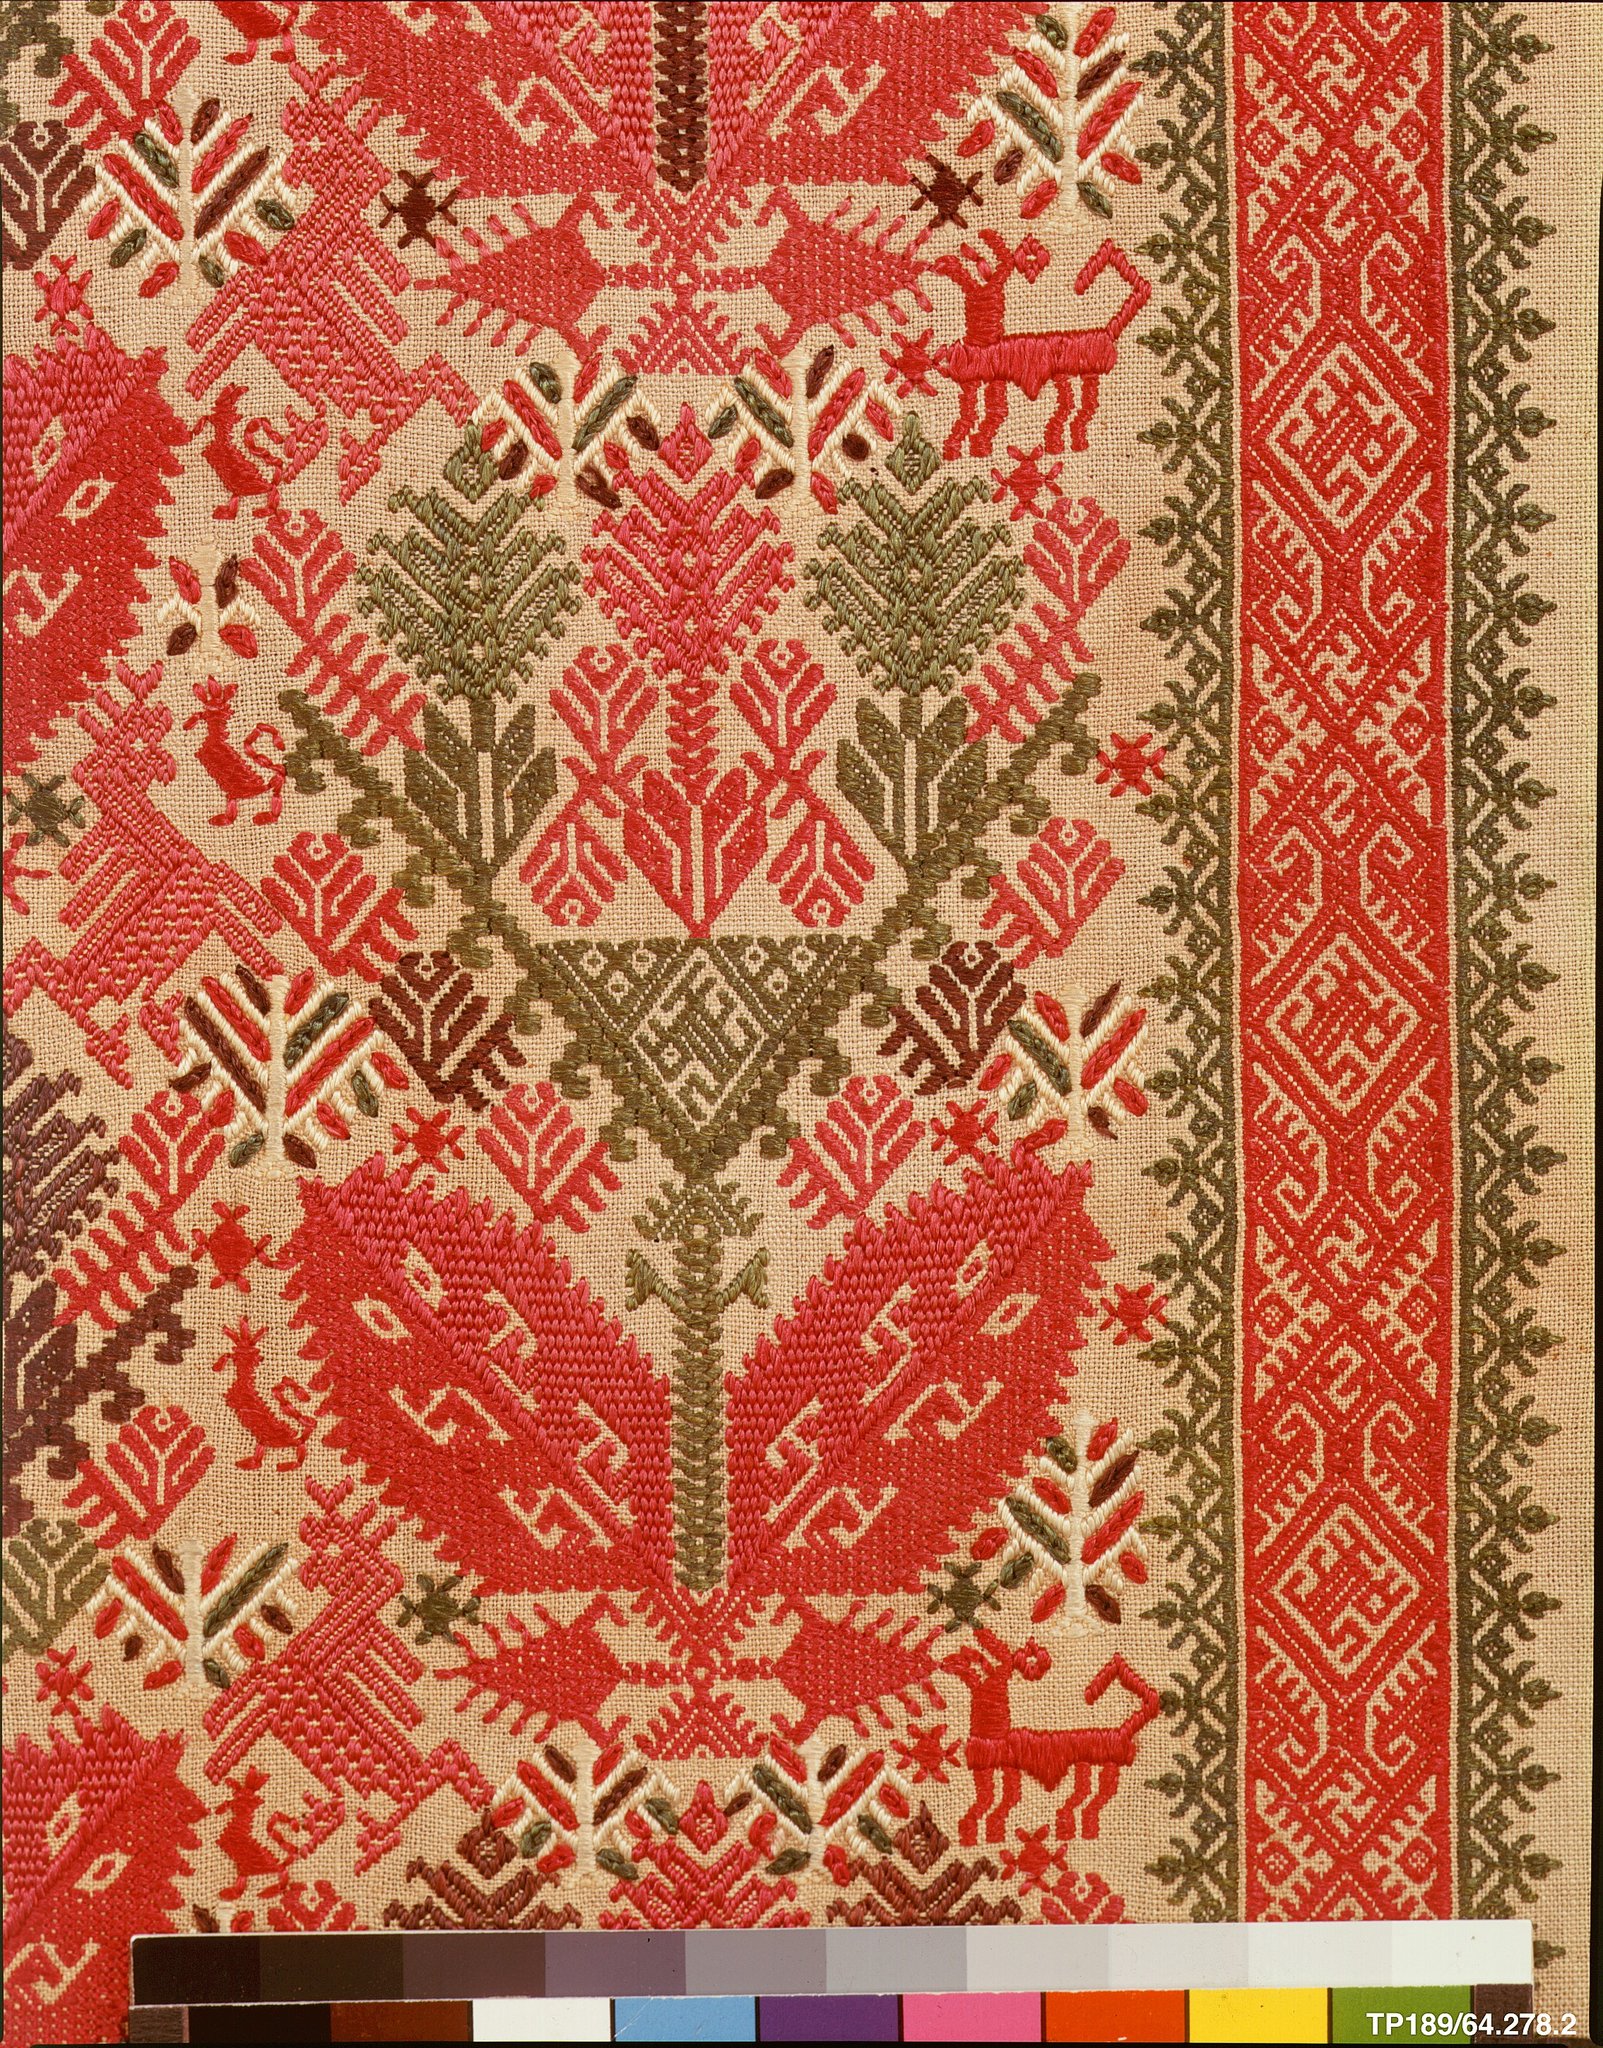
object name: bed curtain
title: Pair of bed curtains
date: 1701-1800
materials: linen, silk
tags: animals